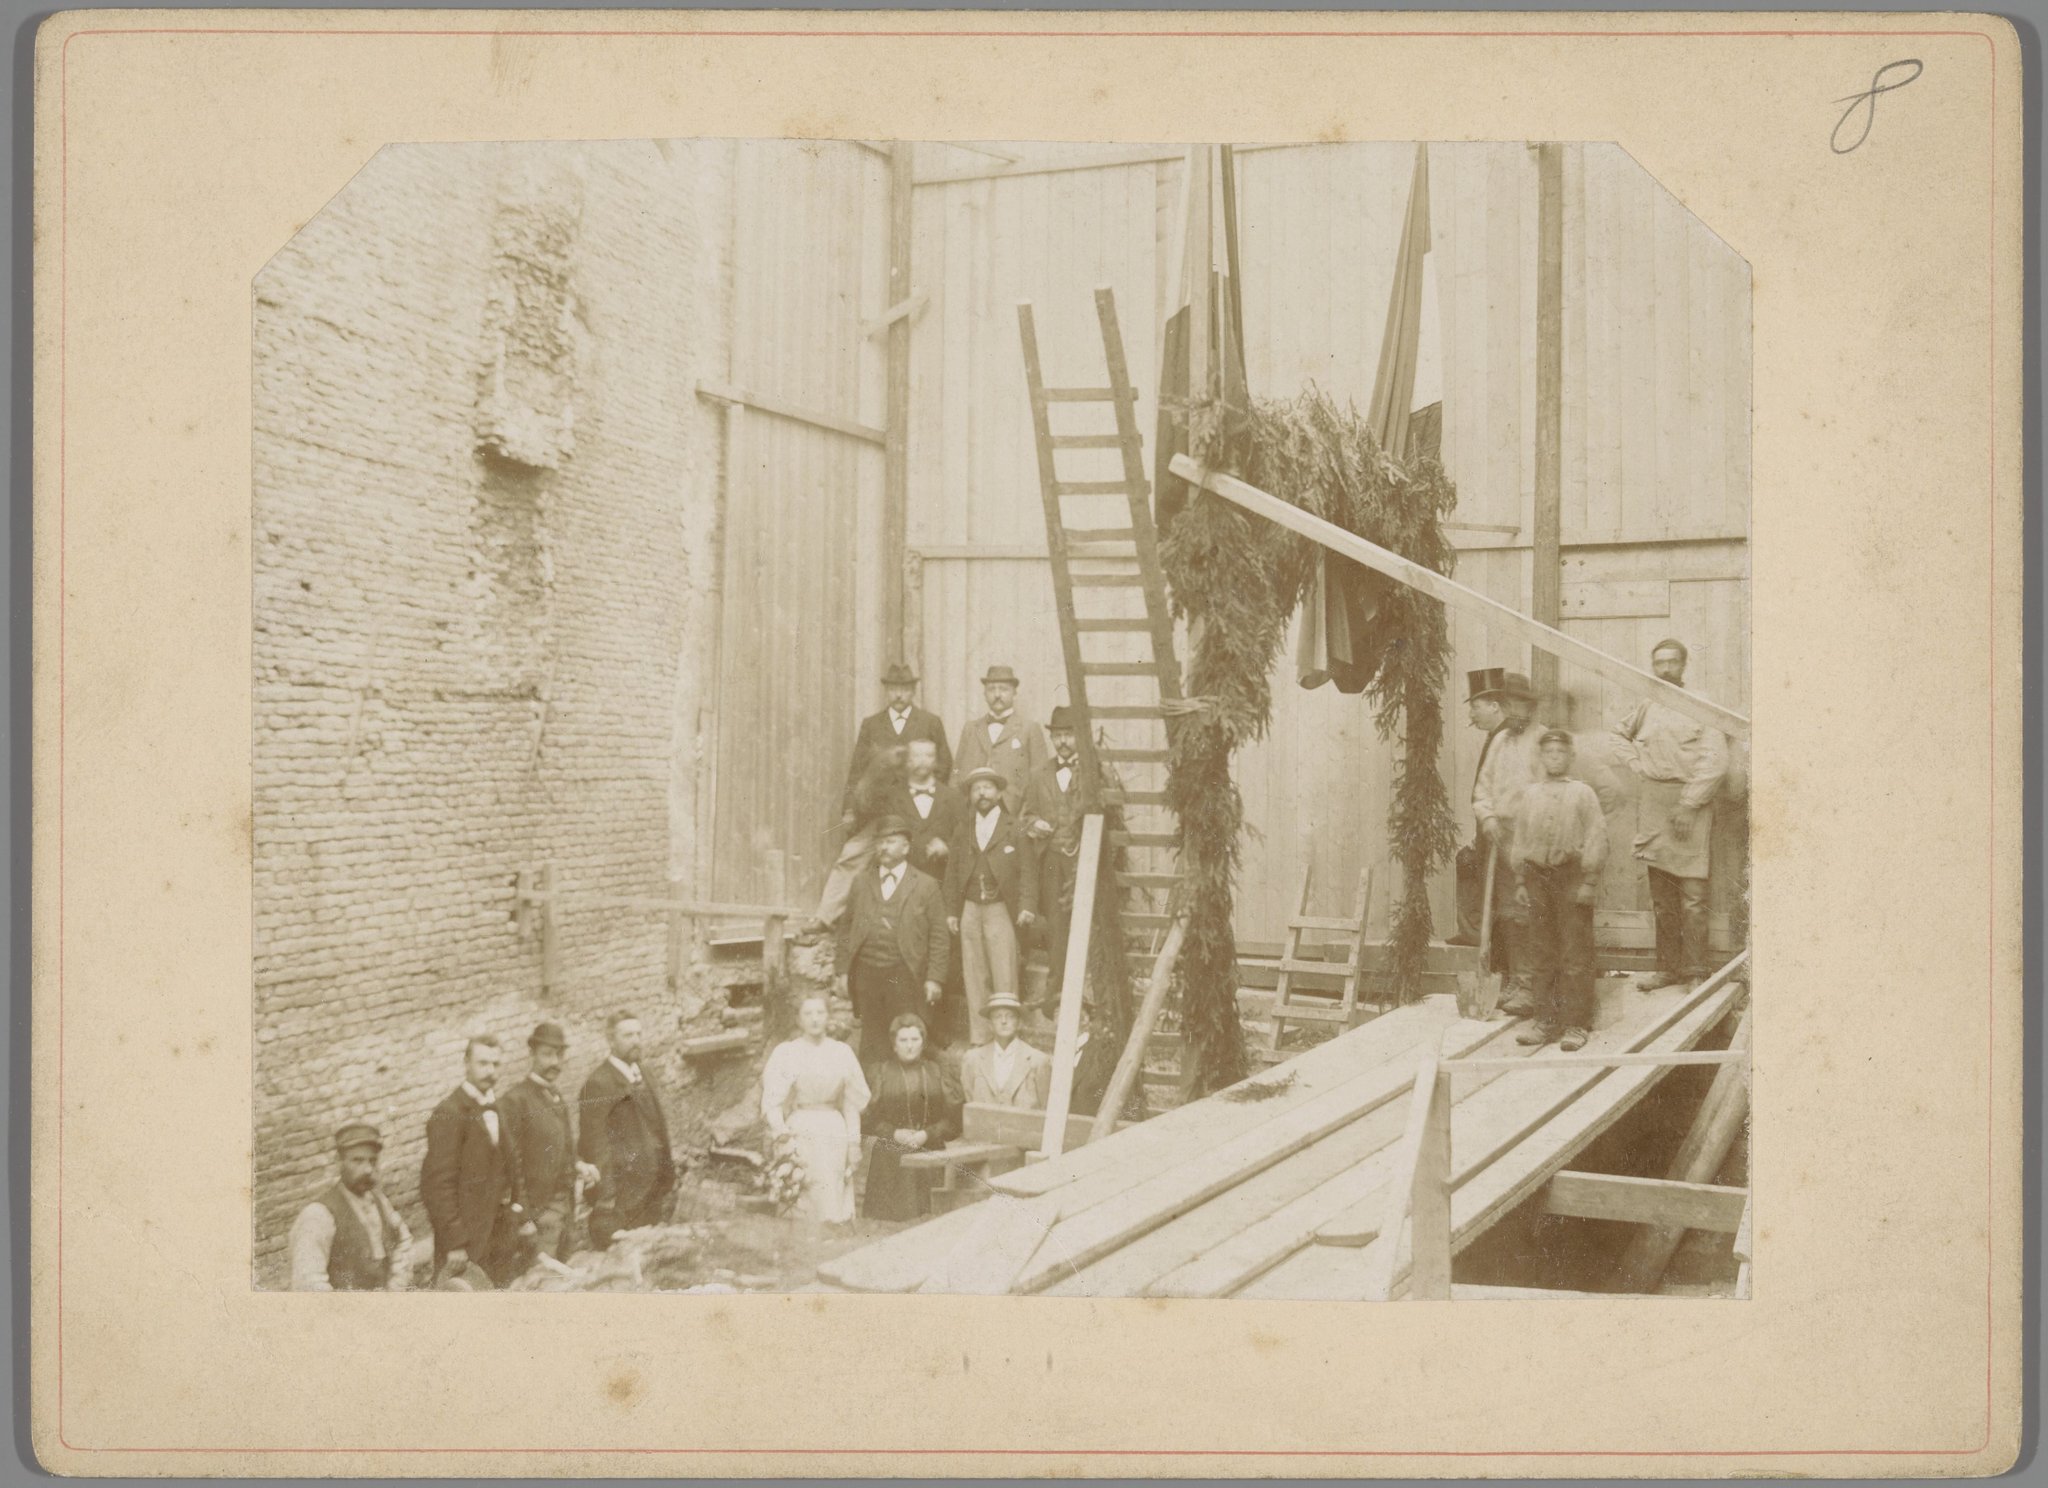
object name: photograph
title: 1e Steenlegging verbouwing Palais Royal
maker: Anonymous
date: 1896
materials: paper, cardboard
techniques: collodion silver print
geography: amsterdam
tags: building activities, rejoicing on special occasions